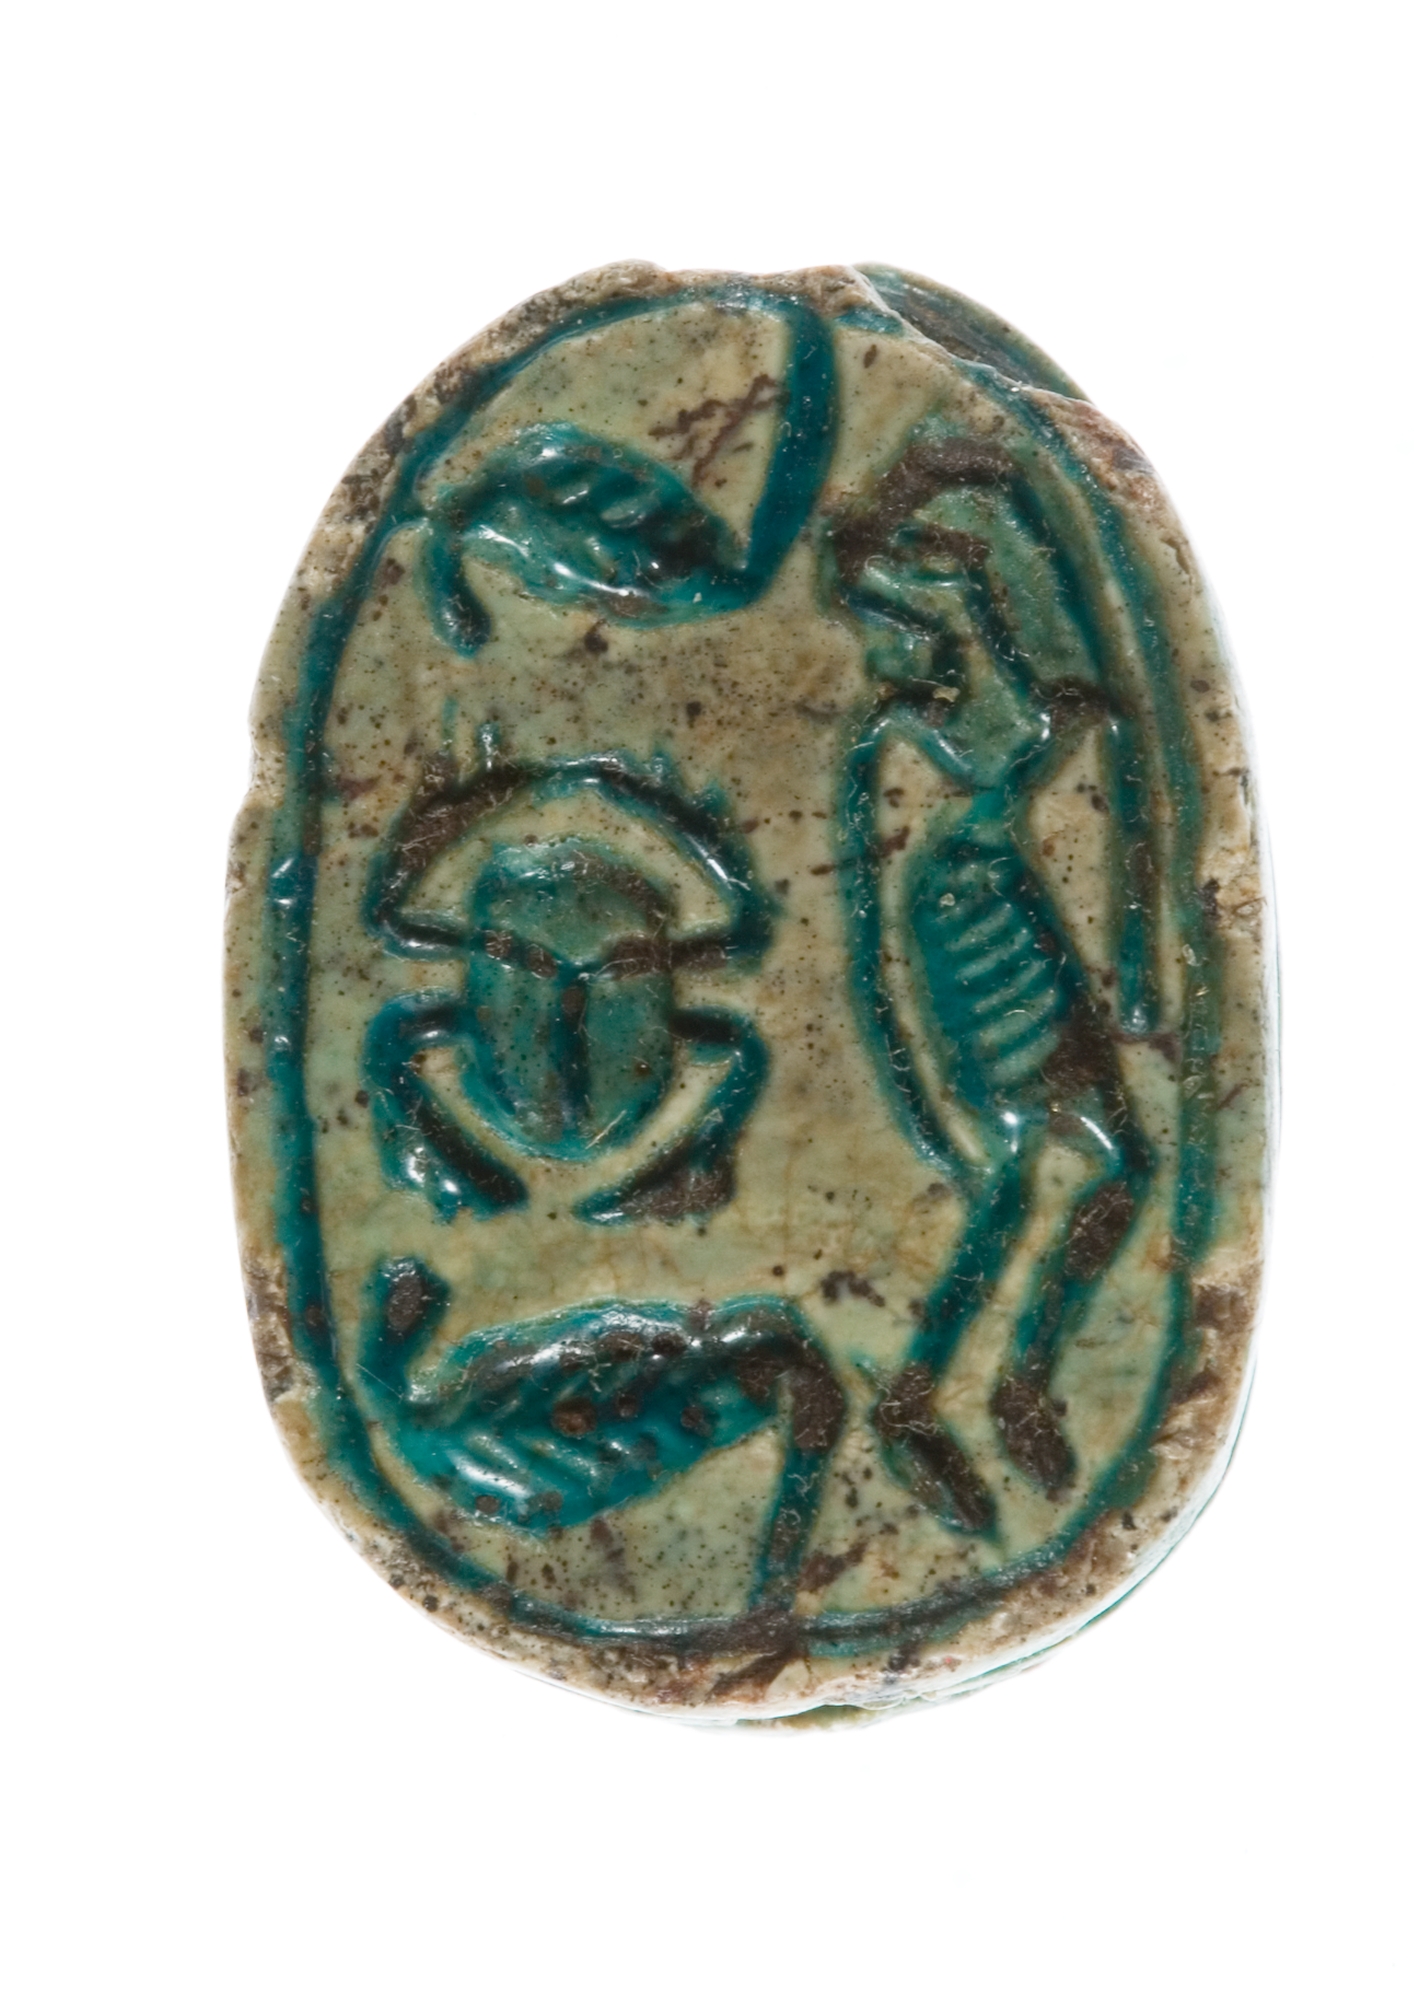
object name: scarab, cobra, ruler emblem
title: Canaanite Scarab Showing a Prostrate Man under Two Cobras and a Scarab (Emblems of a Ruler)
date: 1600-1500 BCE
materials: stone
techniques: glazing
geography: egypt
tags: men,scarabs,snakes